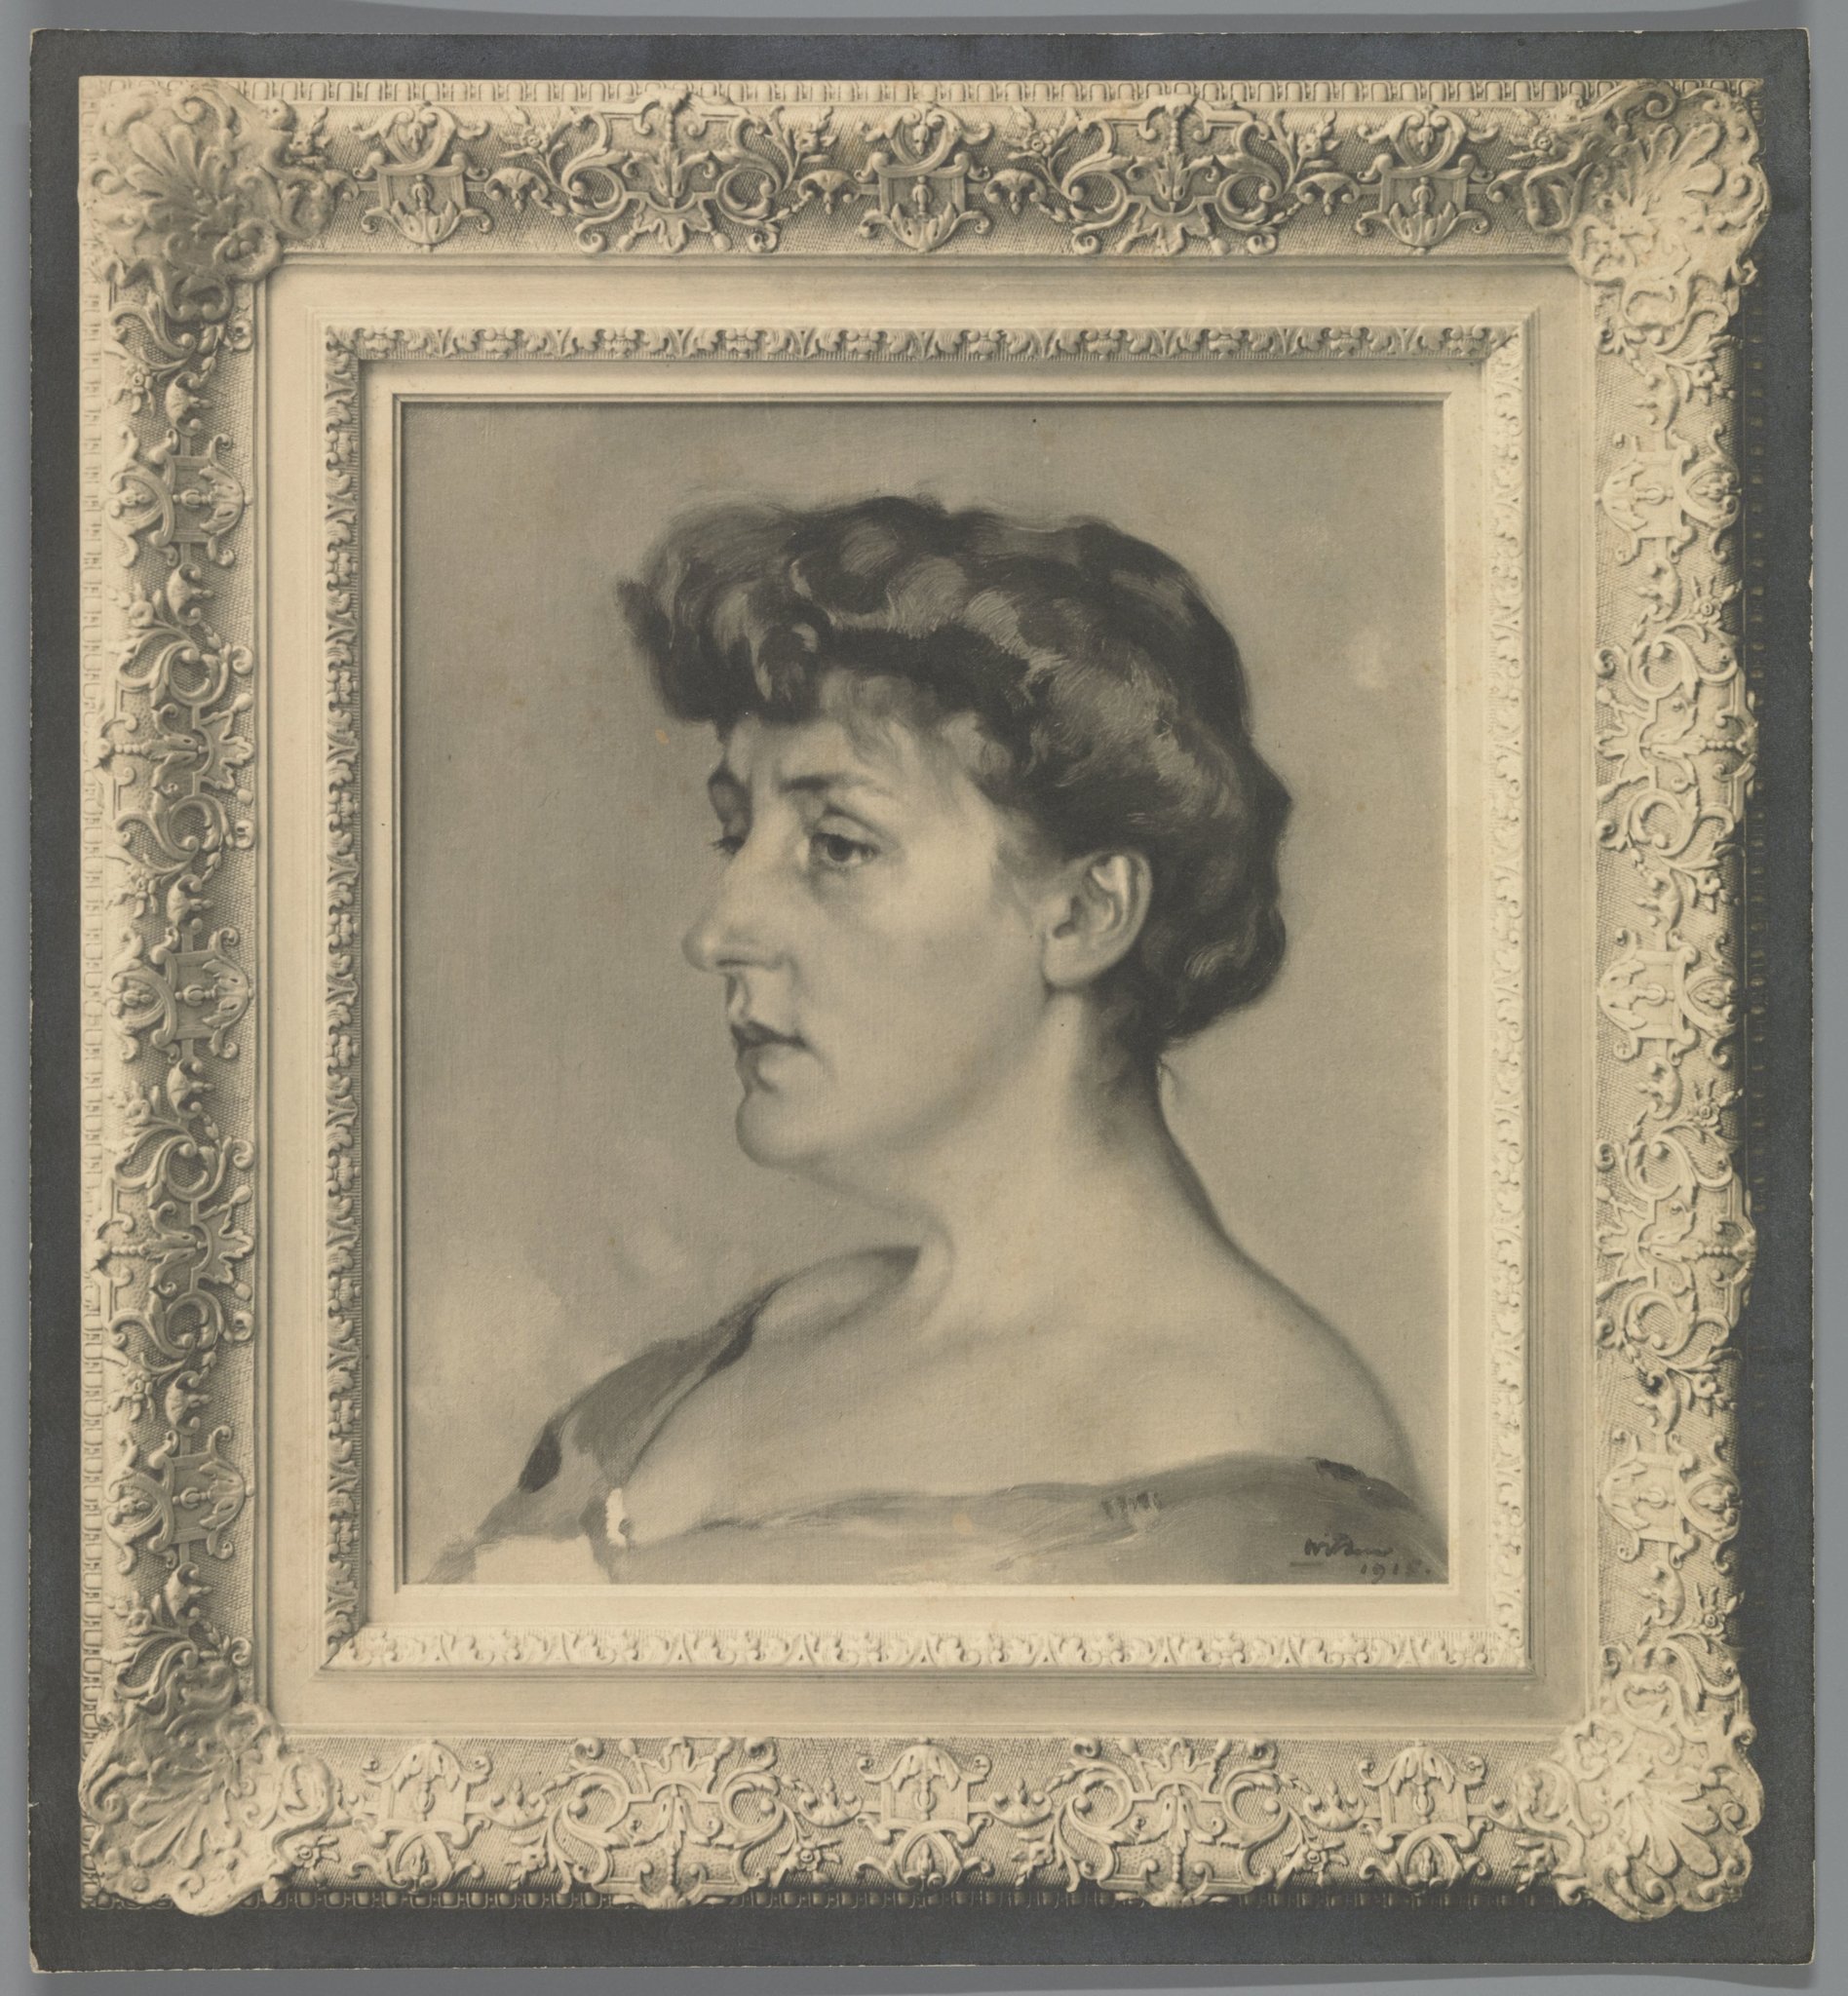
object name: photograph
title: Reproductie naar schilderij van Willem Witsen van een portret van een vrouw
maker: gabriel moulin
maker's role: fotograaf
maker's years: 1872-1945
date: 1860-1915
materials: paper, photographic support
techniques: gelatin silver print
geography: netherlands